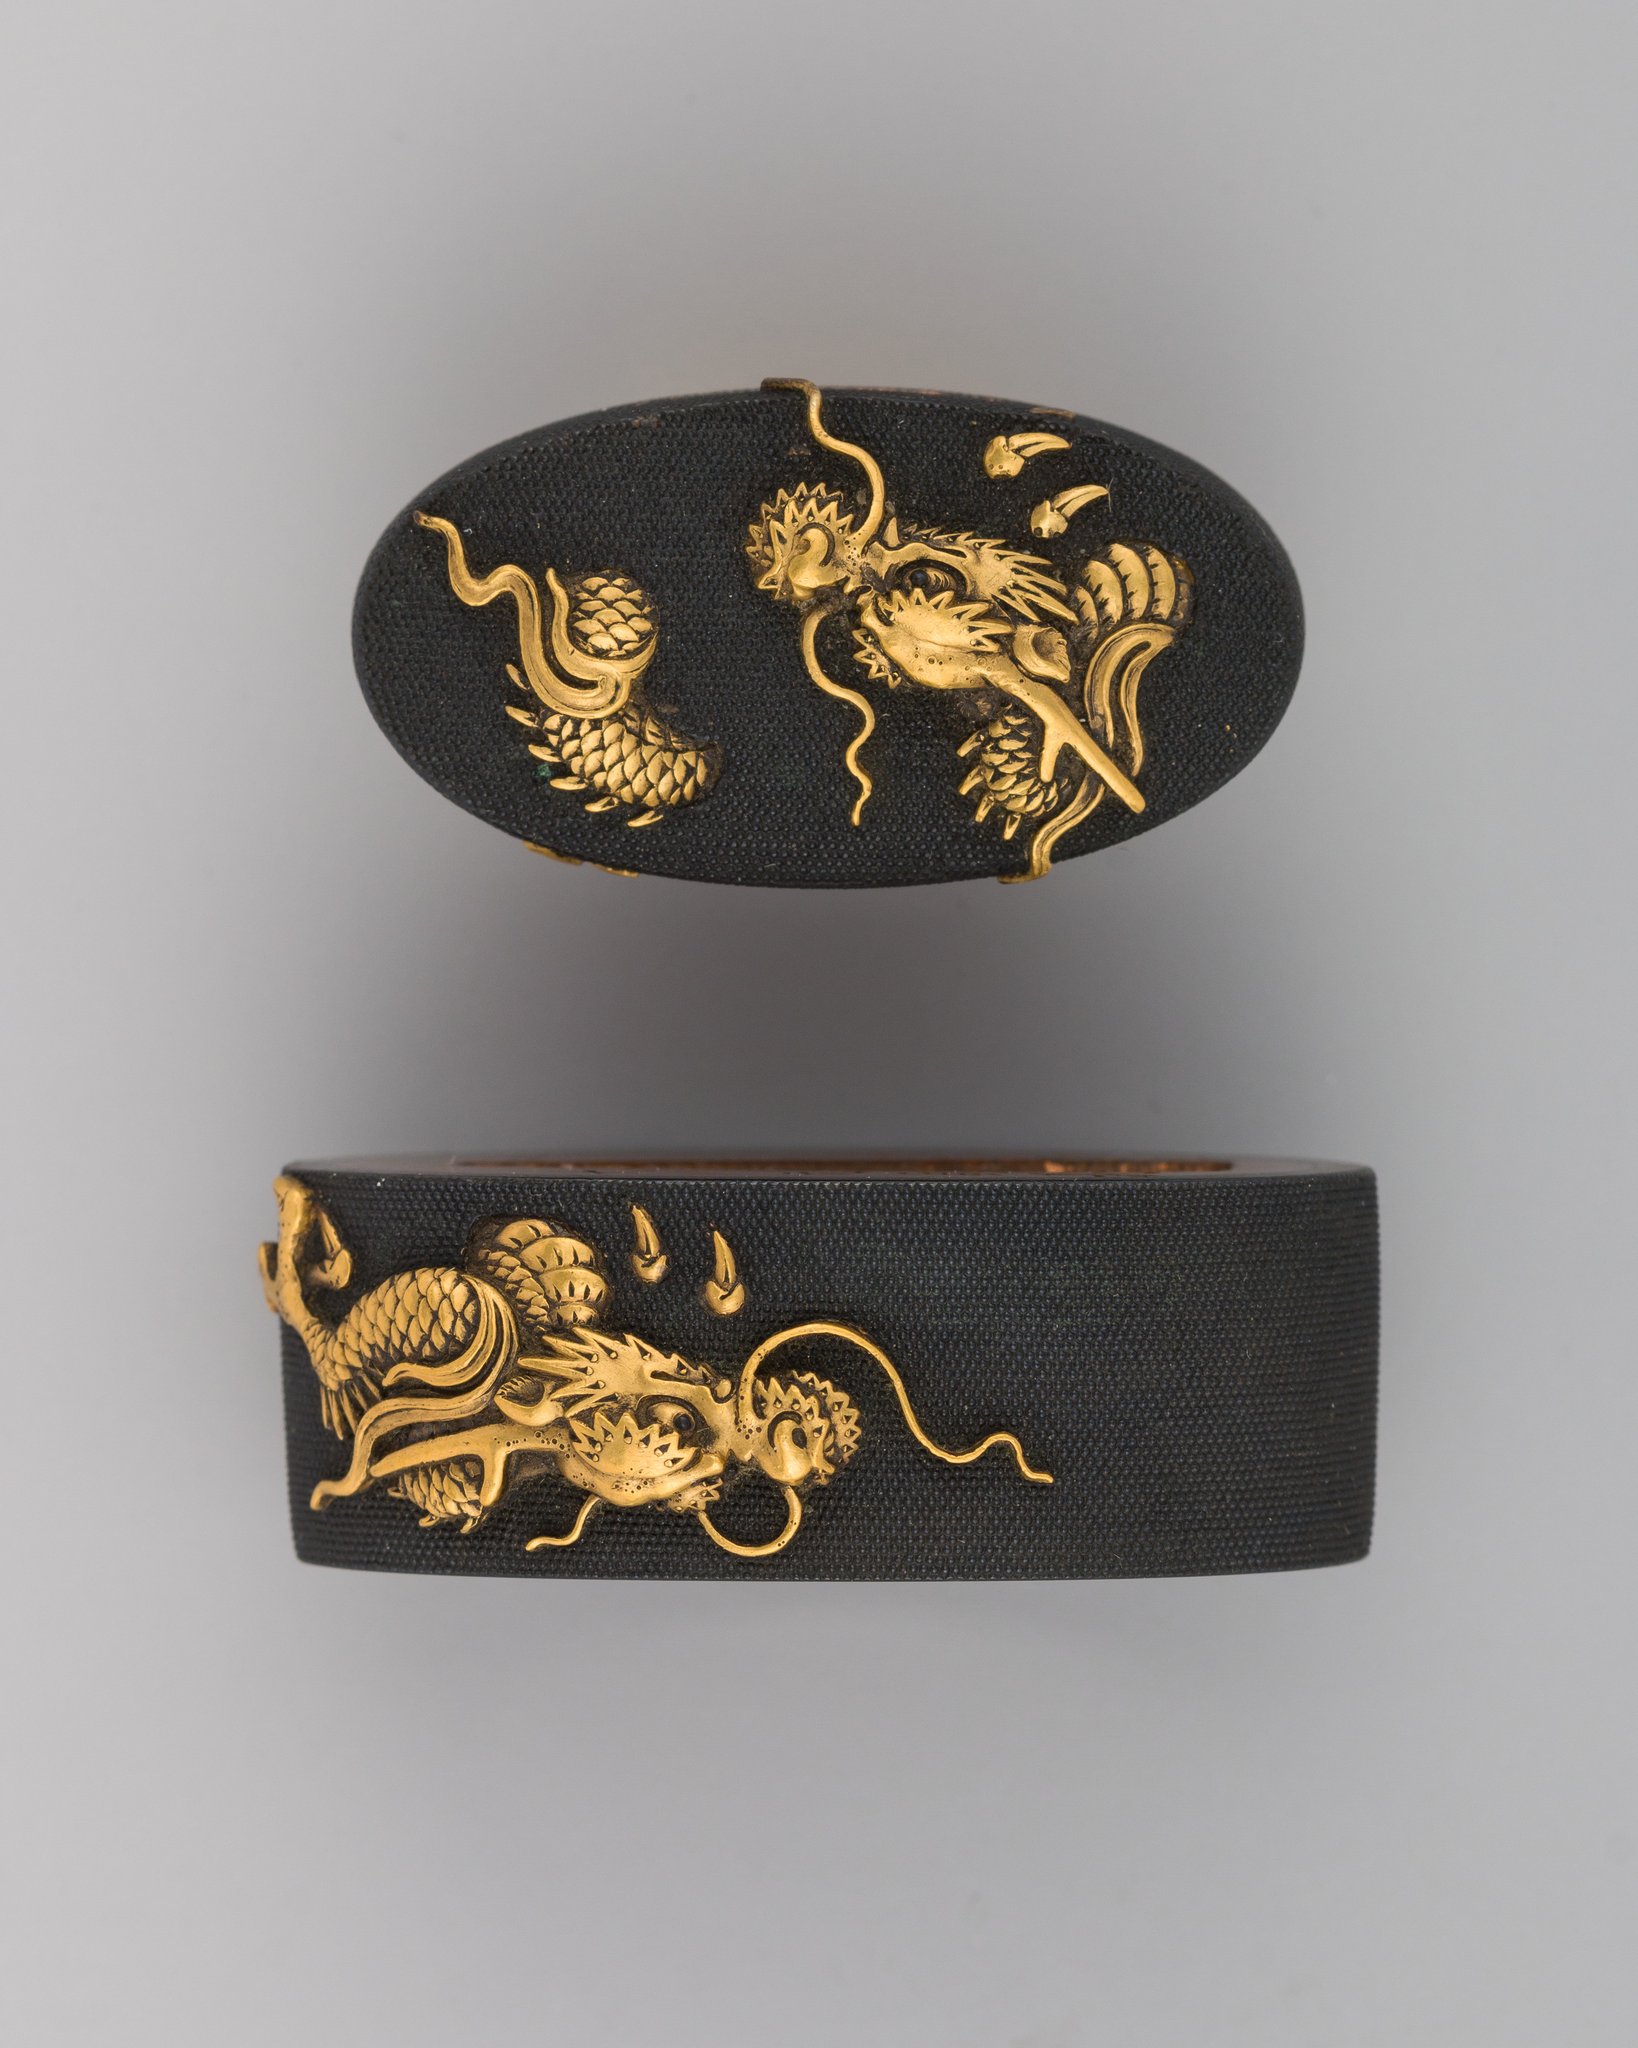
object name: sword hilt collar and pommel fuchigashira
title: Sword-Hilt Collar and Pommel (Fuchigashira)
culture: japanese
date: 1701-1800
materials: gold alloy, gold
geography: japan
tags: dragons